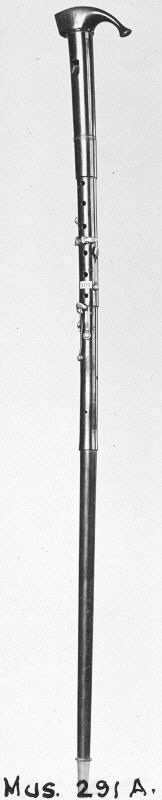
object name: walking stick flageolet in a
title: Walking-Stick Flageolet in A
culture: slovak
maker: franz schölnast (schöllnast)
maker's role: maker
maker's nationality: slovakia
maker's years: 1775-1844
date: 1820-1840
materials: horn, pewter, silver, wood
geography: slovakia